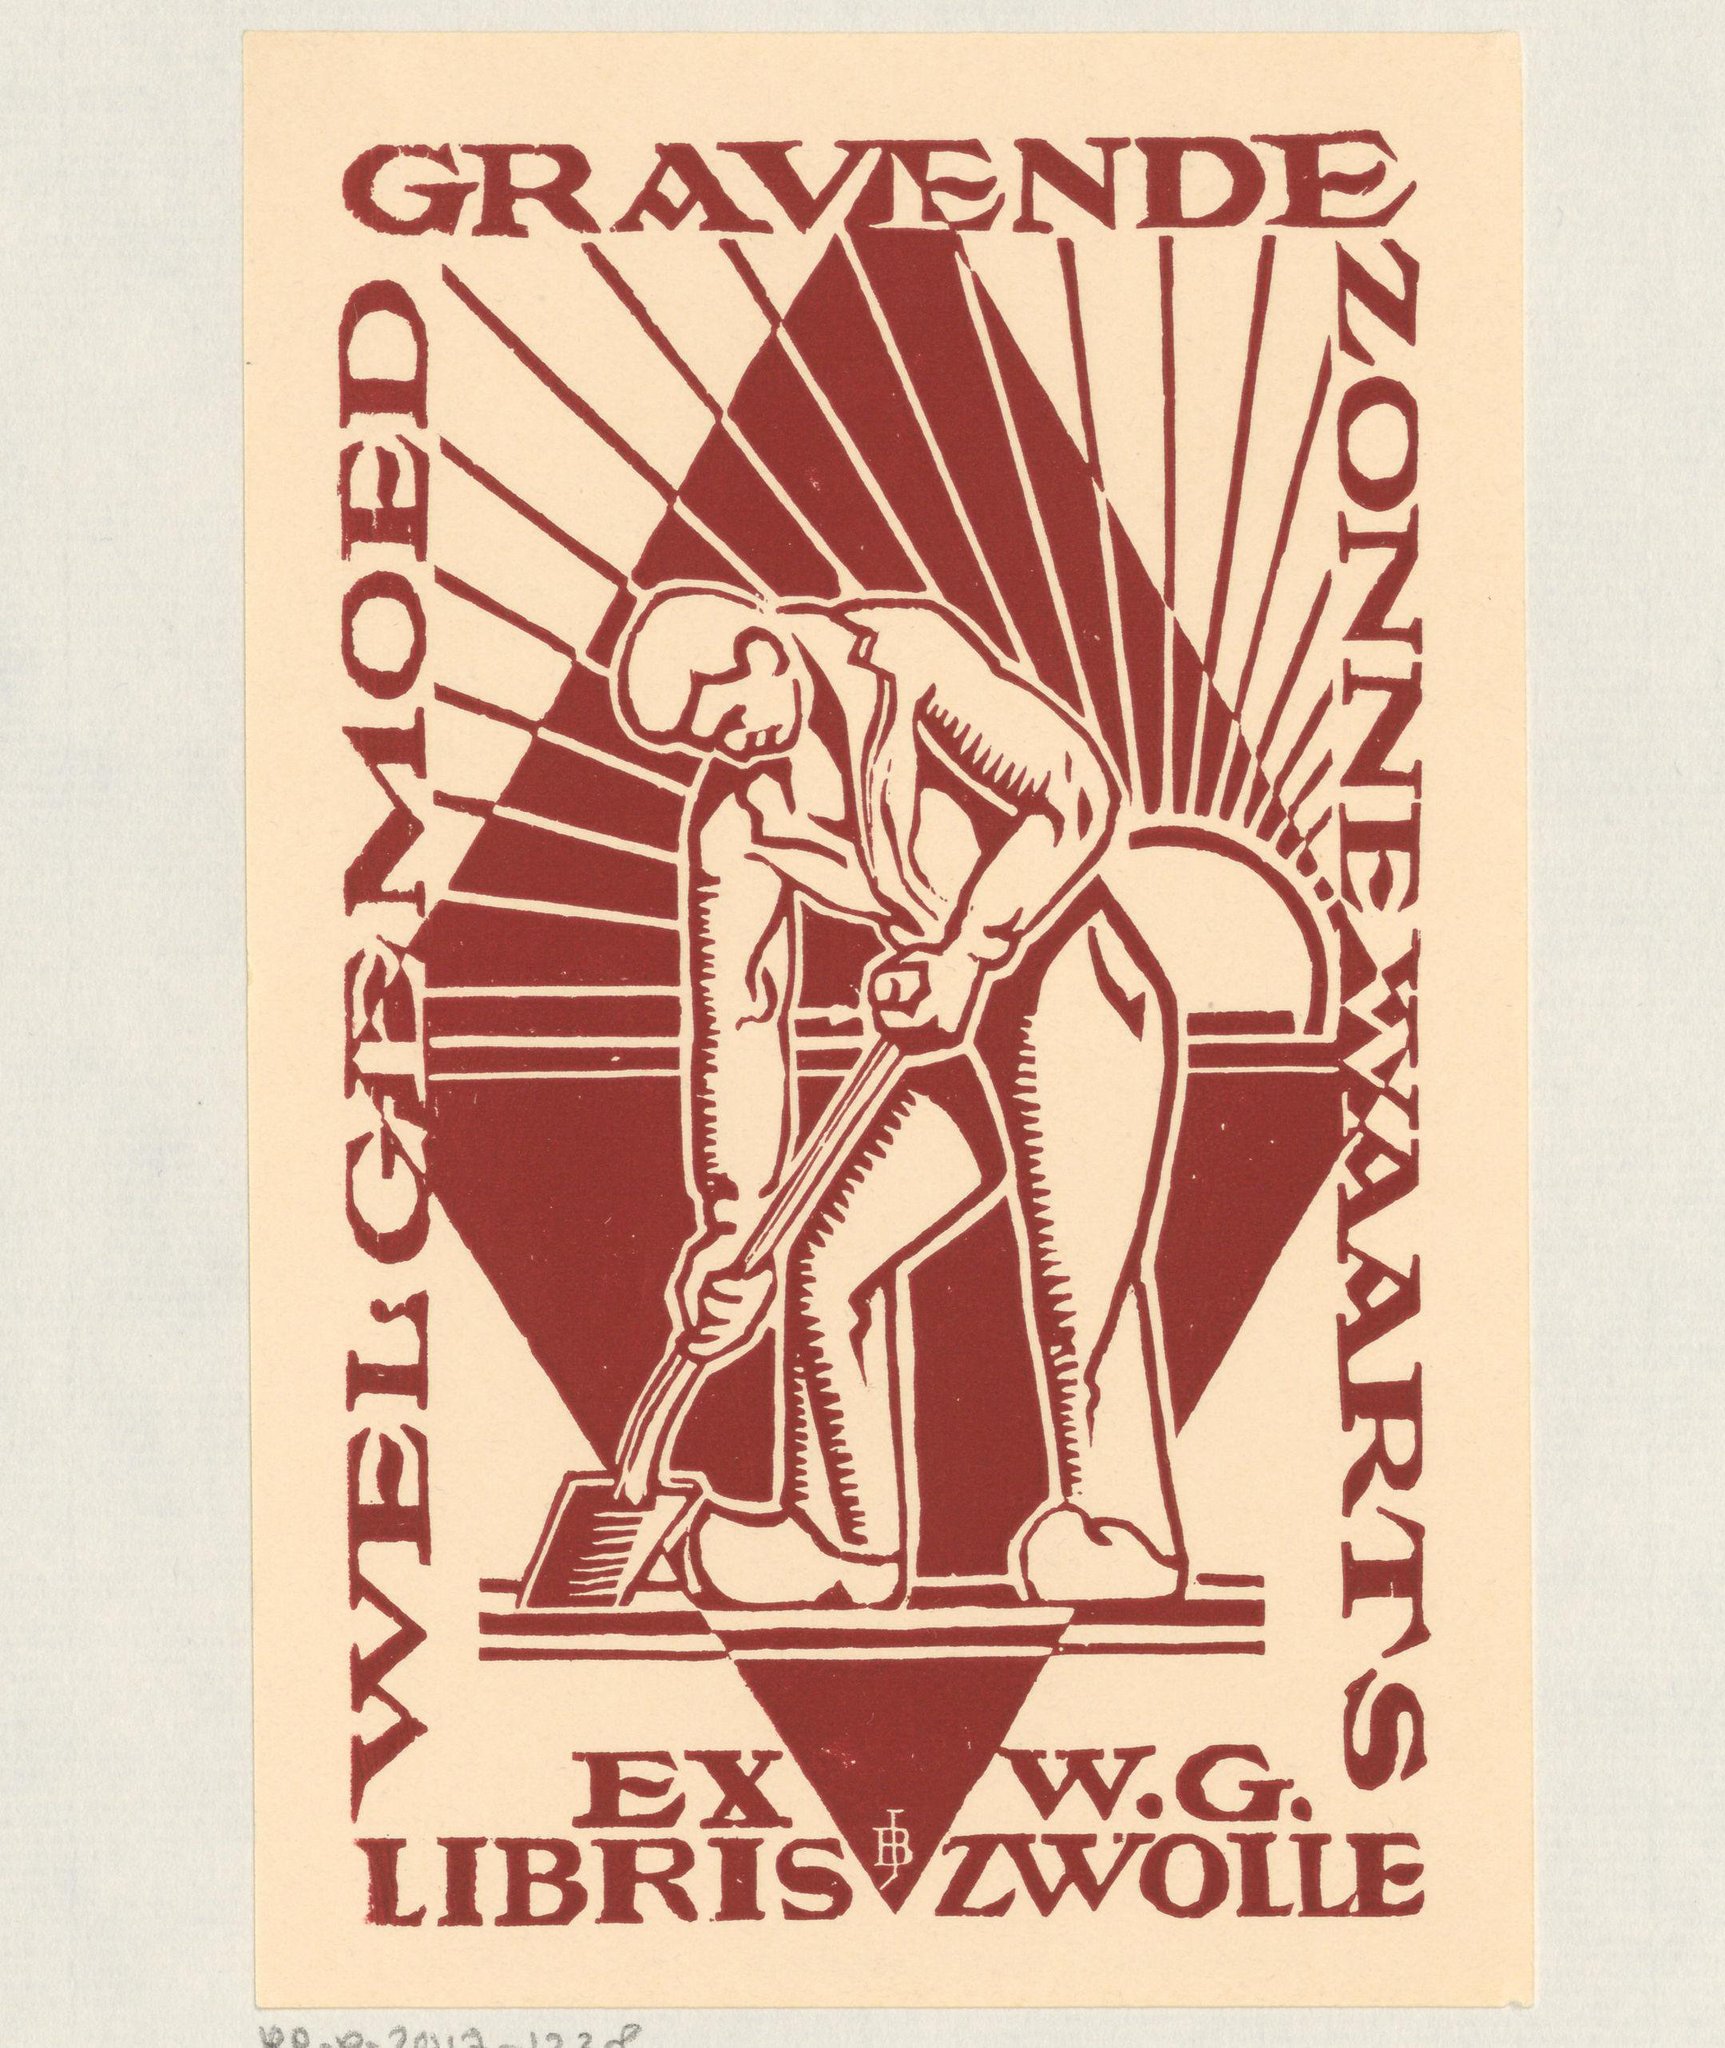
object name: bookplate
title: Welgemoed gravende zonnewaarts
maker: j. van bakkum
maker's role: print maker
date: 1938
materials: paper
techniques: woodcut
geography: netherlands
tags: farmers, sunrise, spading ~ soil cultivation